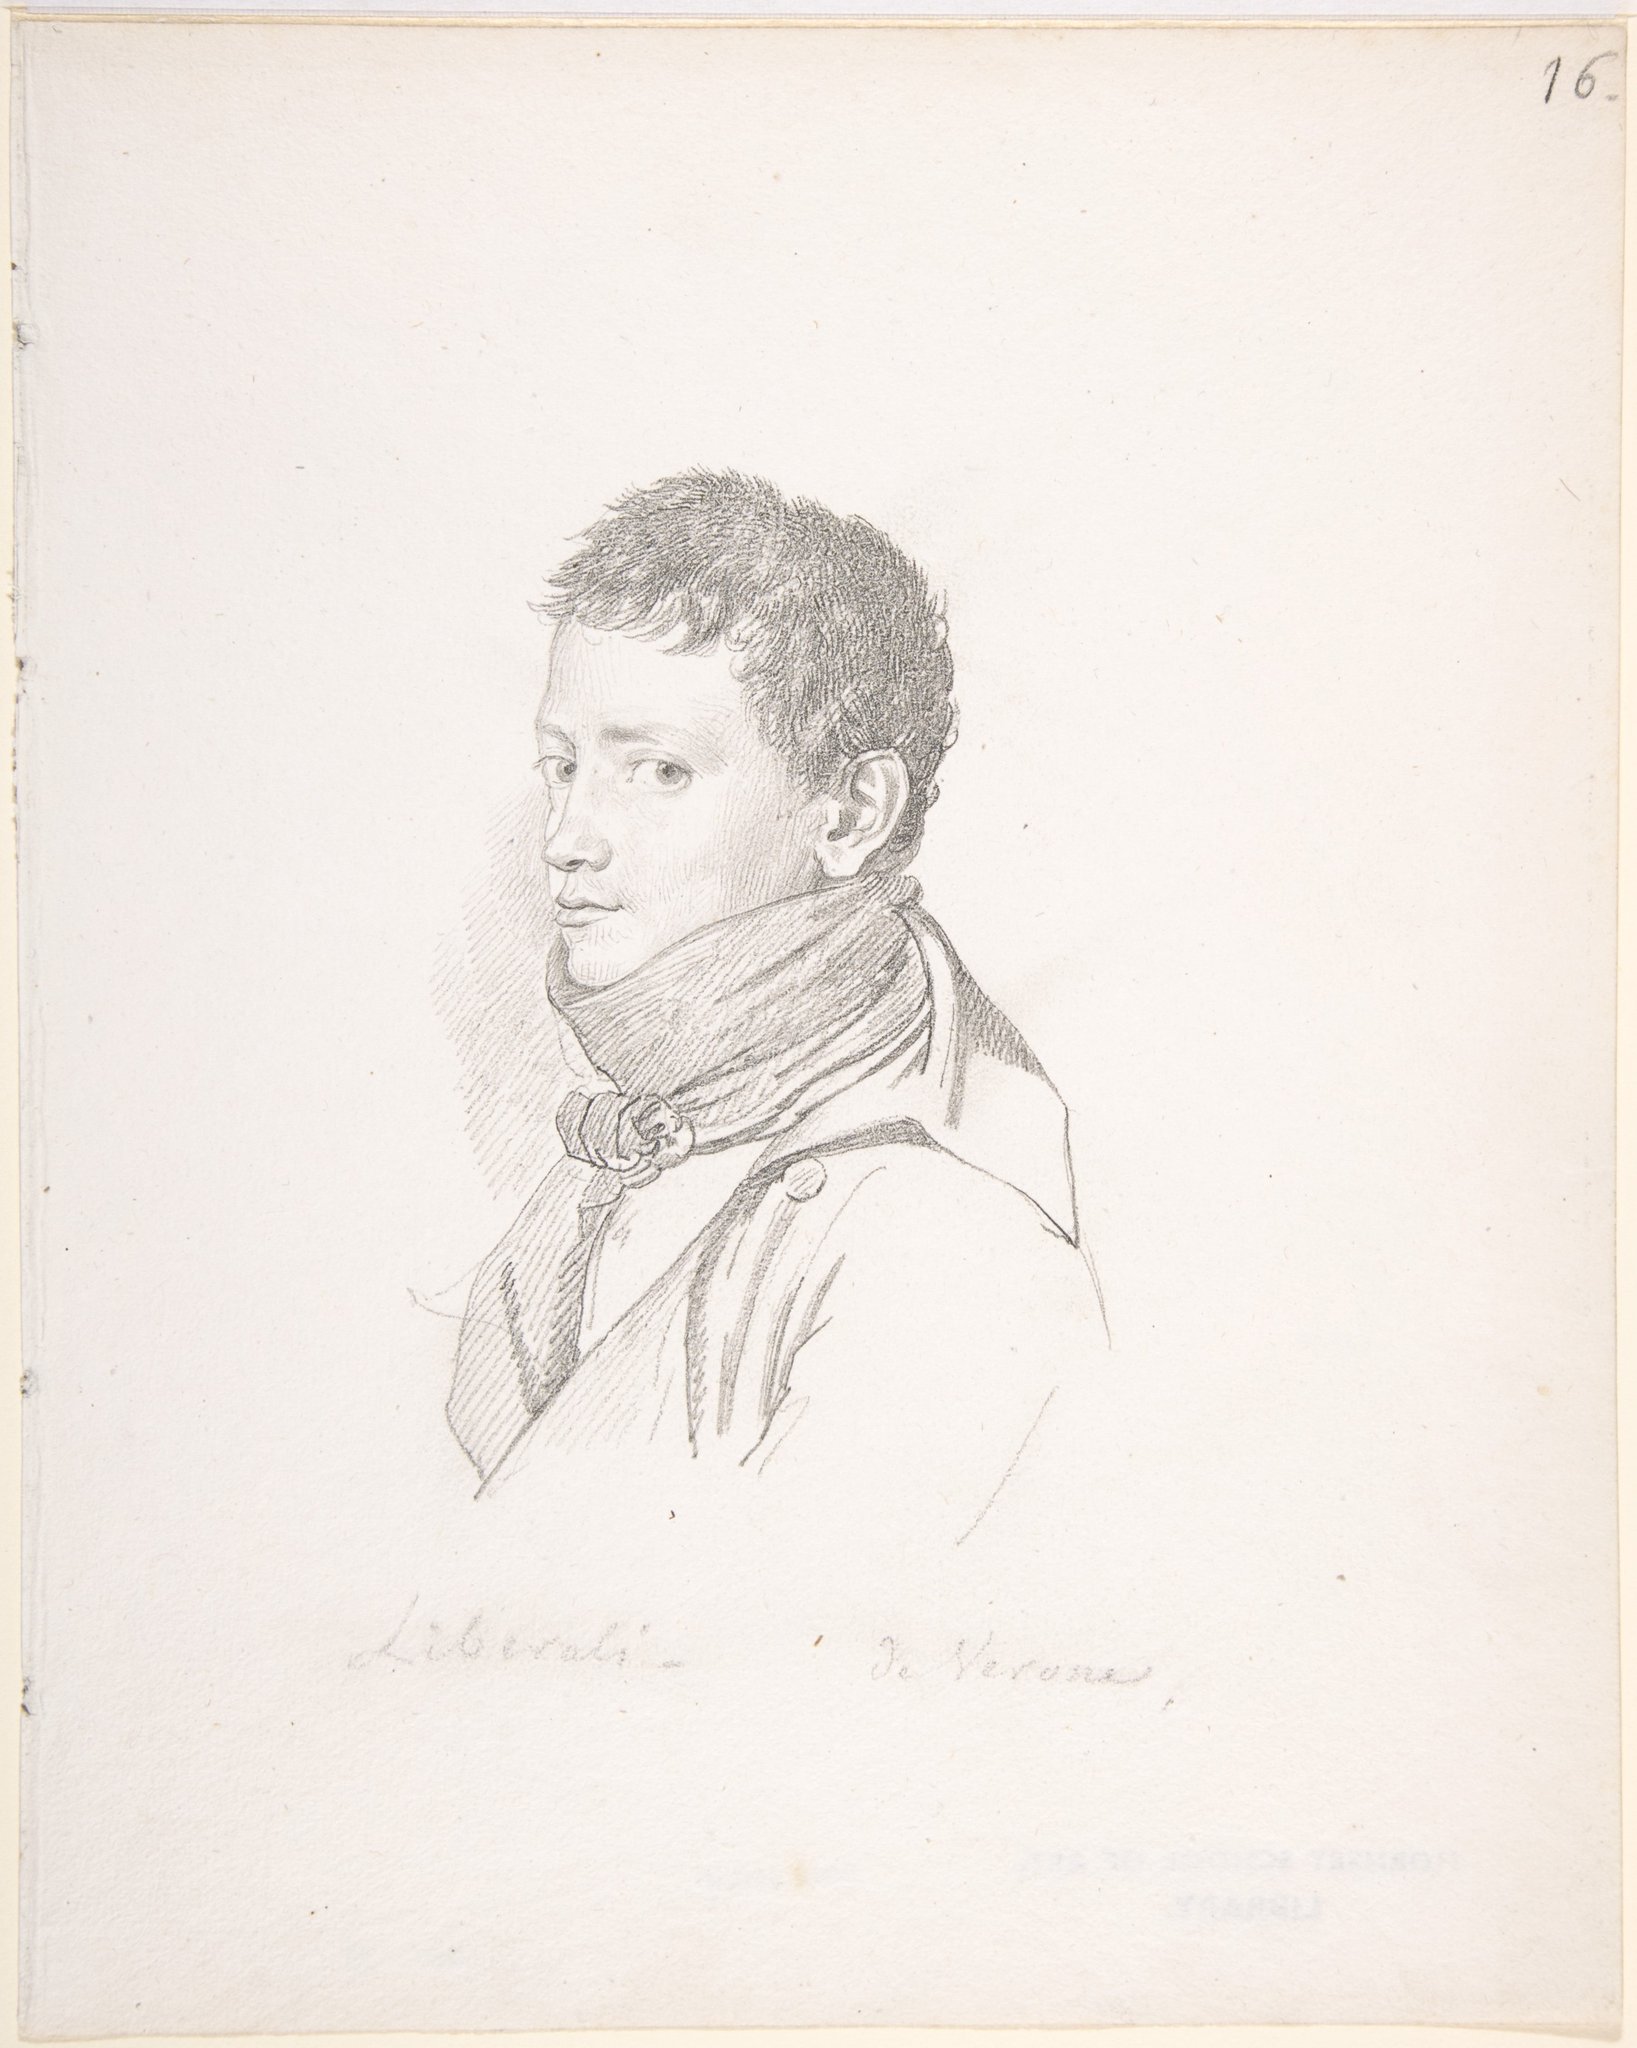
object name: drawing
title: Liberali de Verona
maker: jean-baptiste joseph wicar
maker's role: artist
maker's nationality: french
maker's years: 1762-1834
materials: crayon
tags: men,portraits